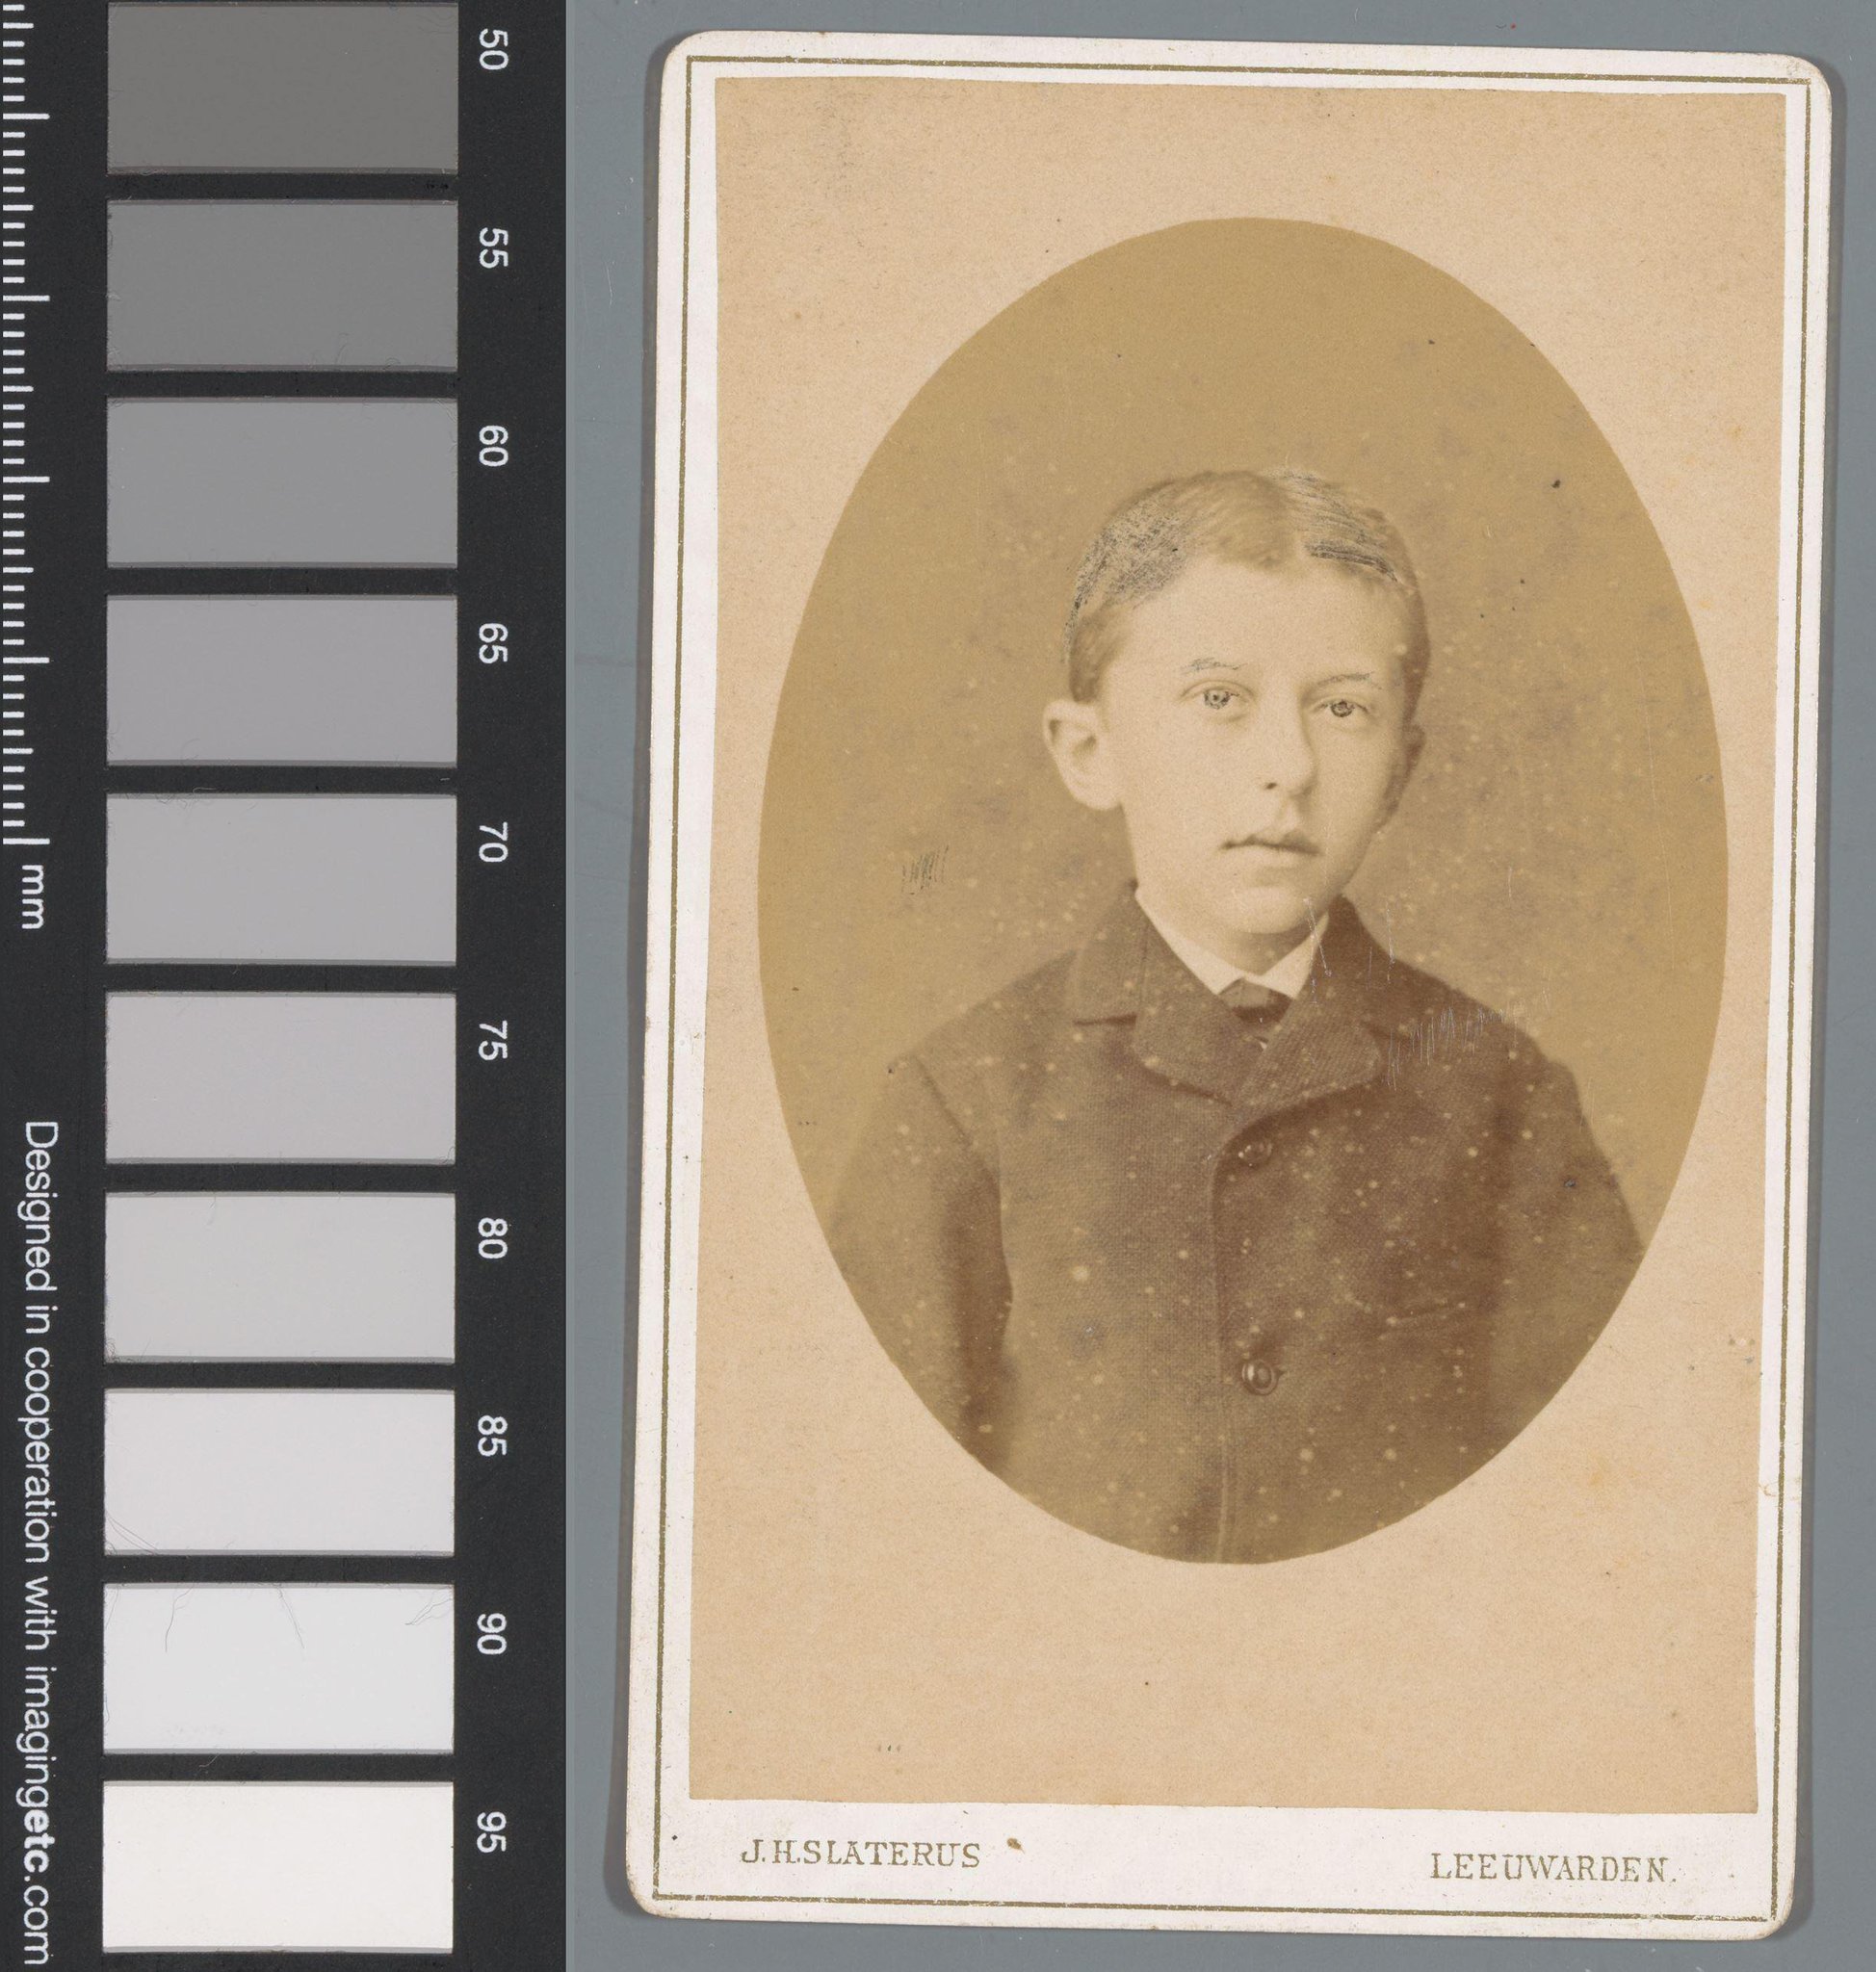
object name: carte de visite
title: Portret van een onbekende jongen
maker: idanus hendrikus slaterus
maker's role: fotograaf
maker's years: 1846-1921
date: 1873-1892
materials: cardboard, paper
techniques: albumen print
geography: leeuwarden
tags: boy (child between toddler and youth), historical persons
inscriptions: inscription: ‘PHOTOGRAPHIE/ I. H. Slaterus/ LEEUWARDEN/ Weerd K. 13./ hoek Bagynestraat.’